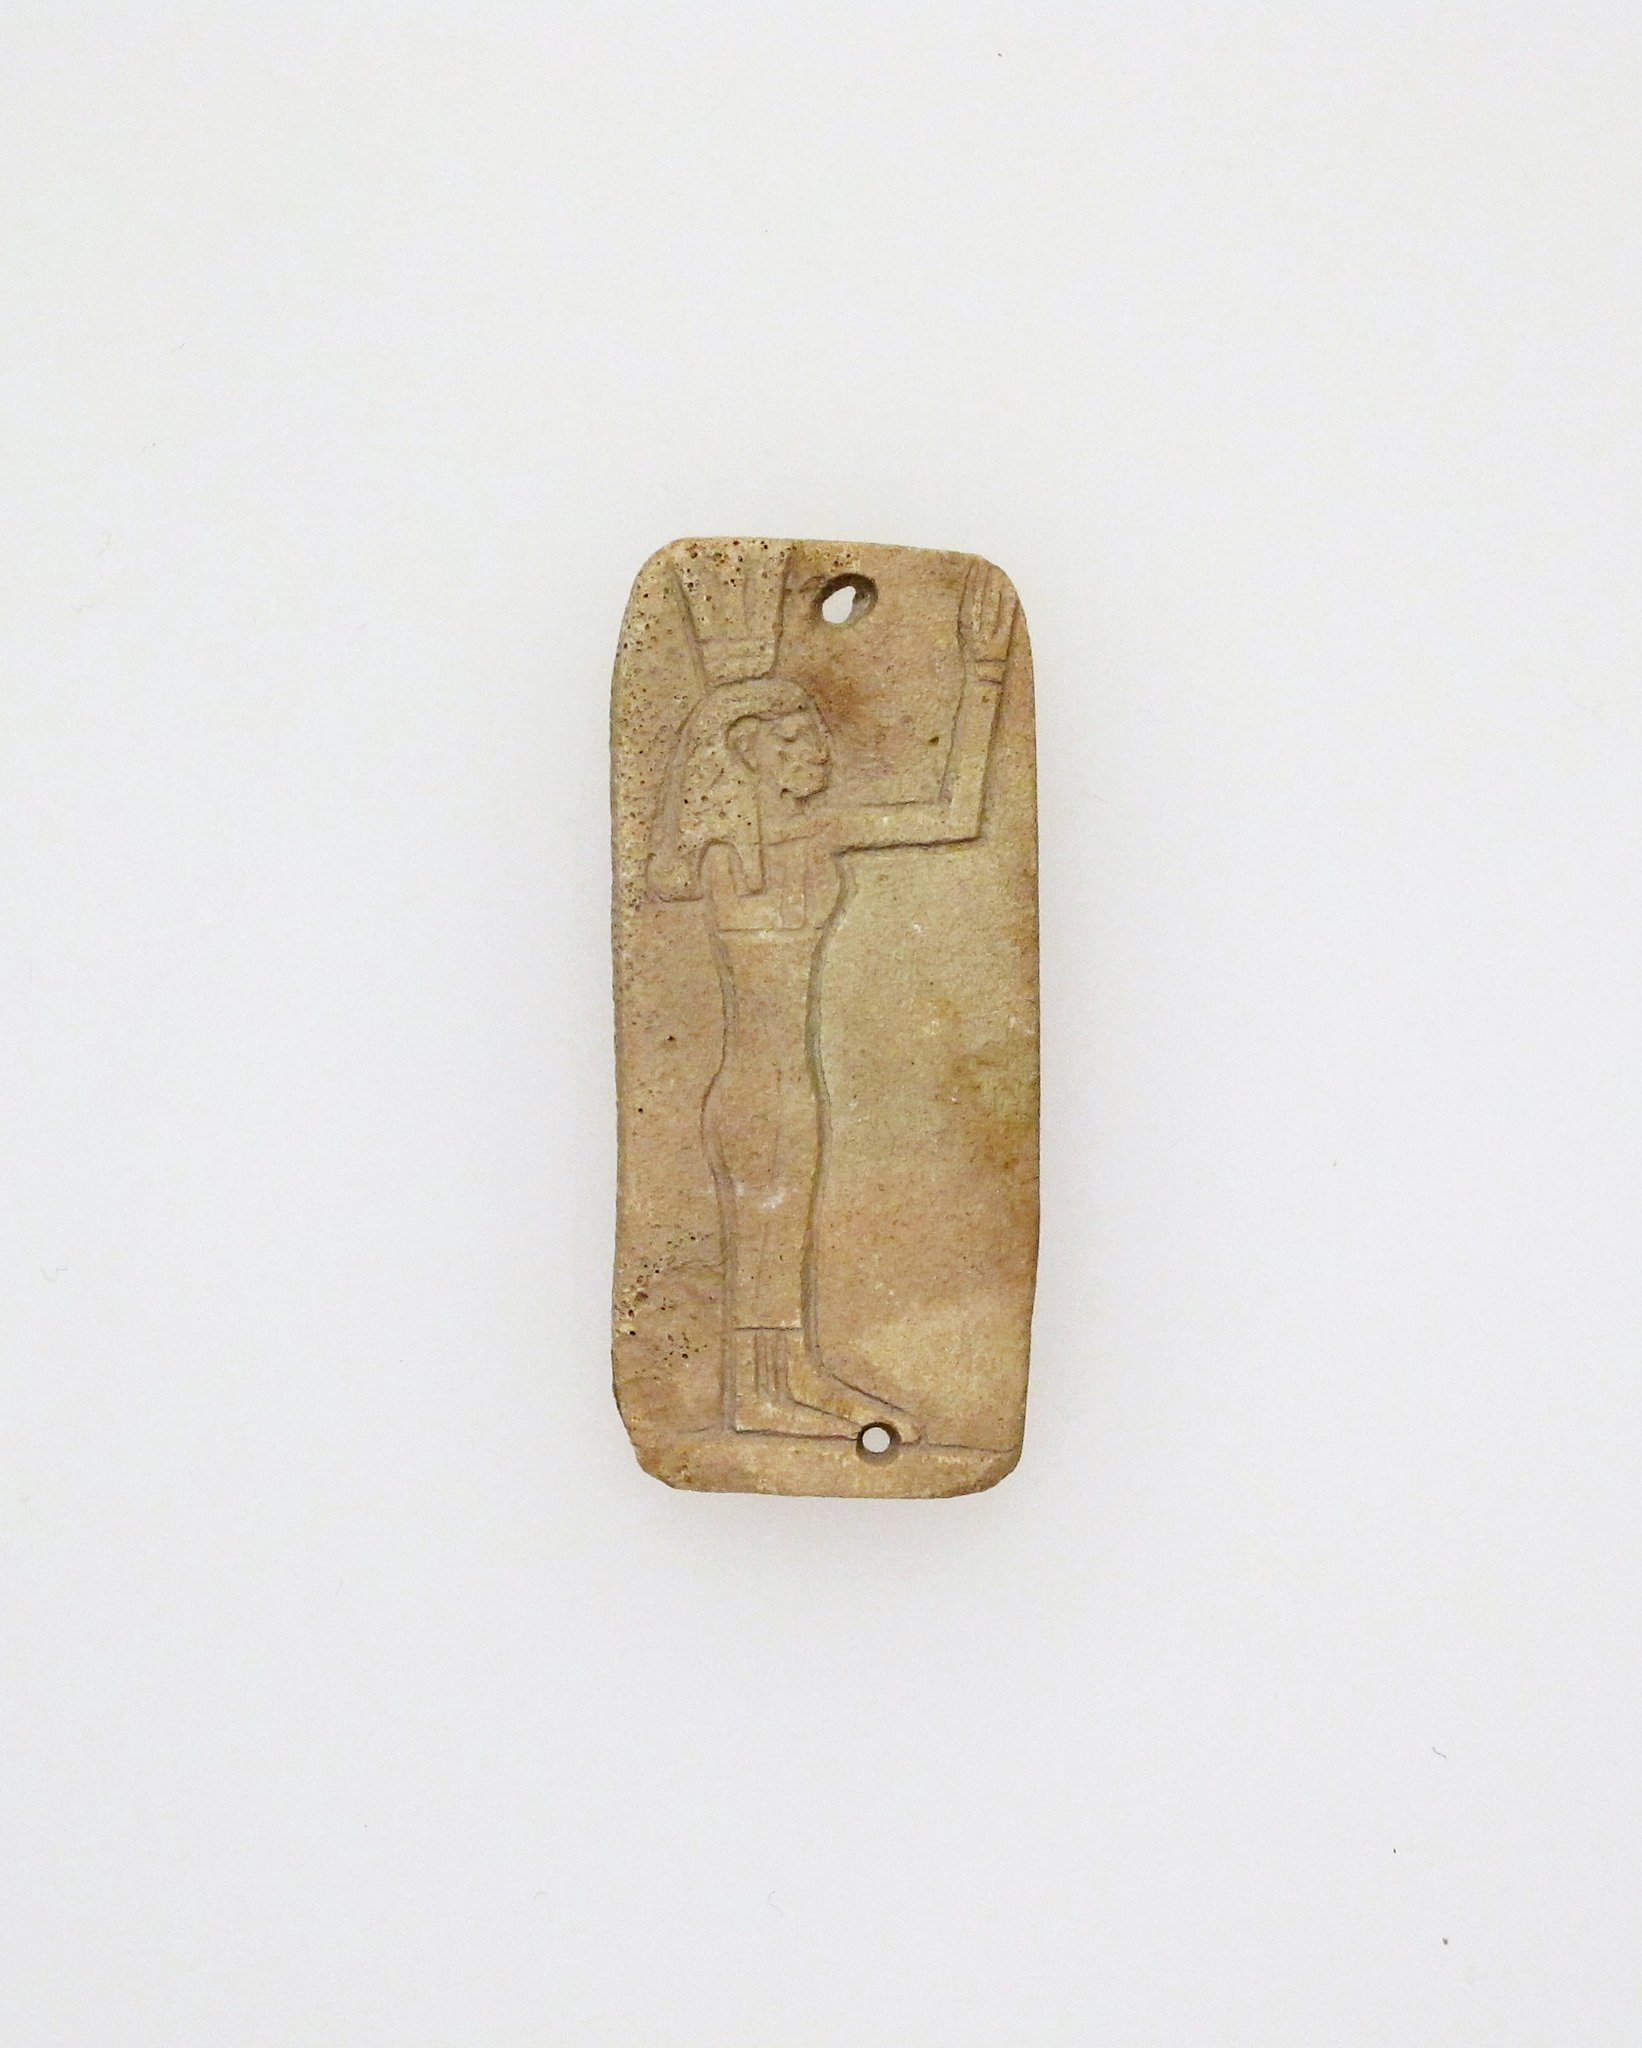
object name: plaque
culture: egyptian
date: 600-301 BCE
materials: terracotta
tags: human figures